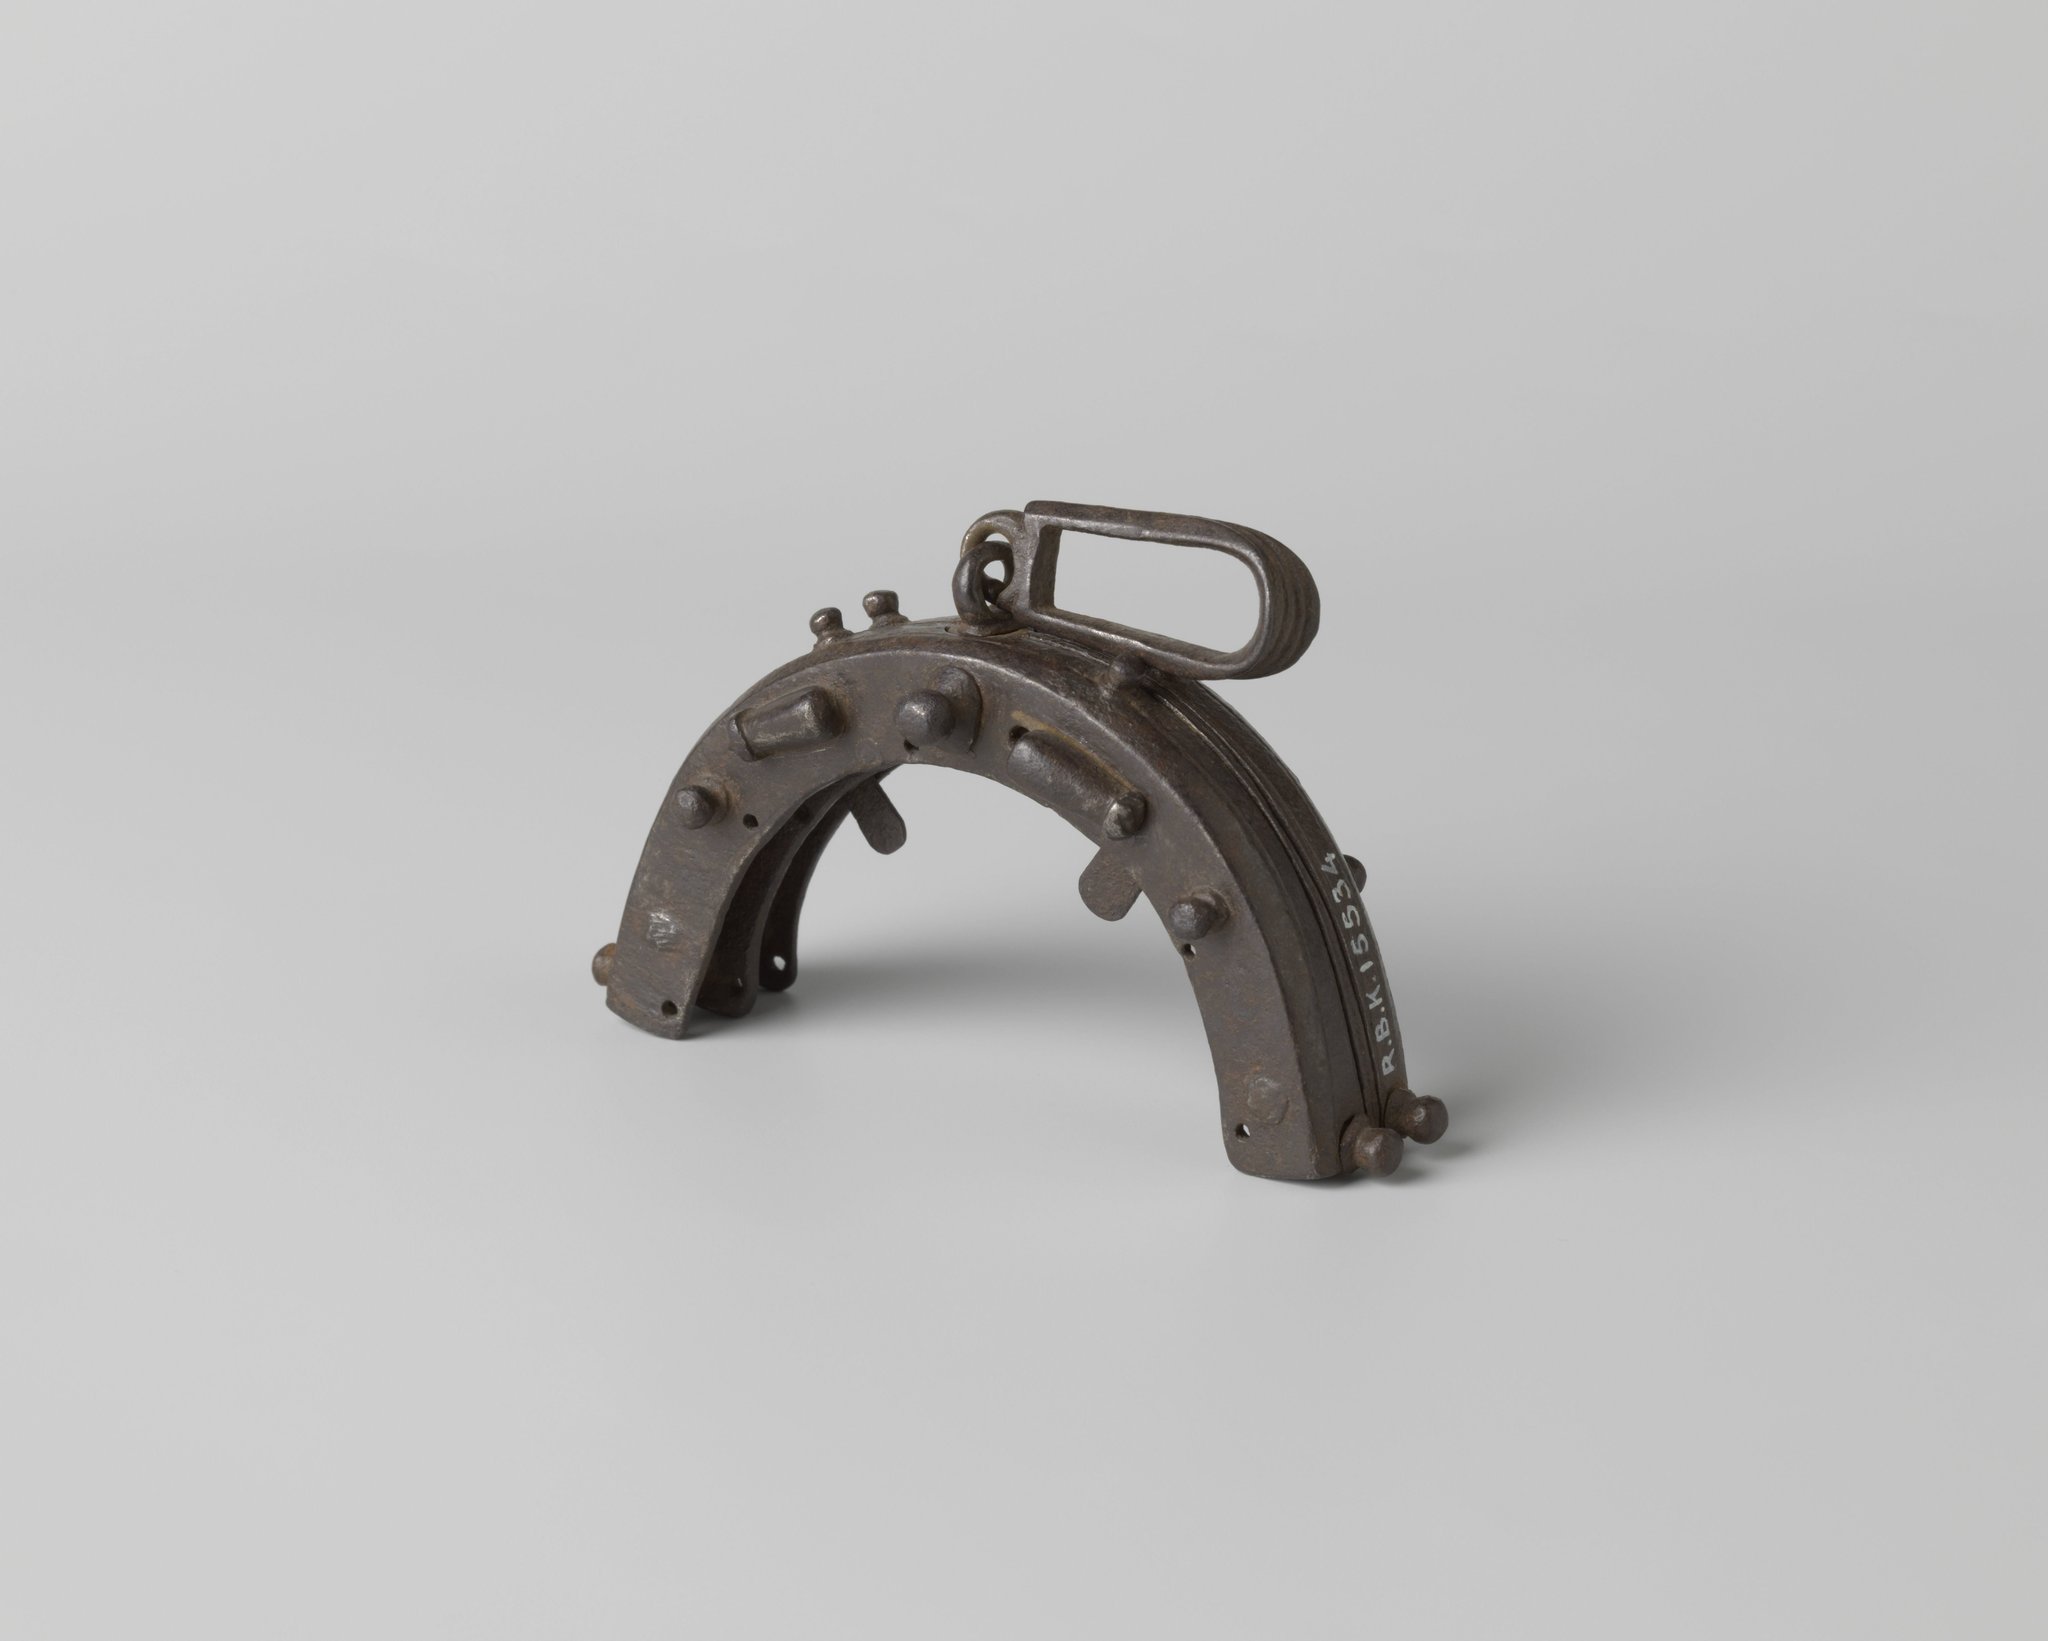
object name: tasbeugel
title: Tasbeugel van smeedijzer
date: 1500-1600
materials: iron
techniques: engraving, forging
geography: netherlands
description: Een smeedijzeren beugel van een dubbele beugeltas of beurs hangende aan een dito lus gesmeed in de vorm van een samengeknepen, gerekt leeren riem, en met een oogje verbonden aan een oog, dat aan de midden beugelvleugel is gehecht. De beugel is halfcirkelvormig en scharniert aan de beide uiteinden op twee zijvleugels, over welke rug twee gegraveerde lijnen lopen.